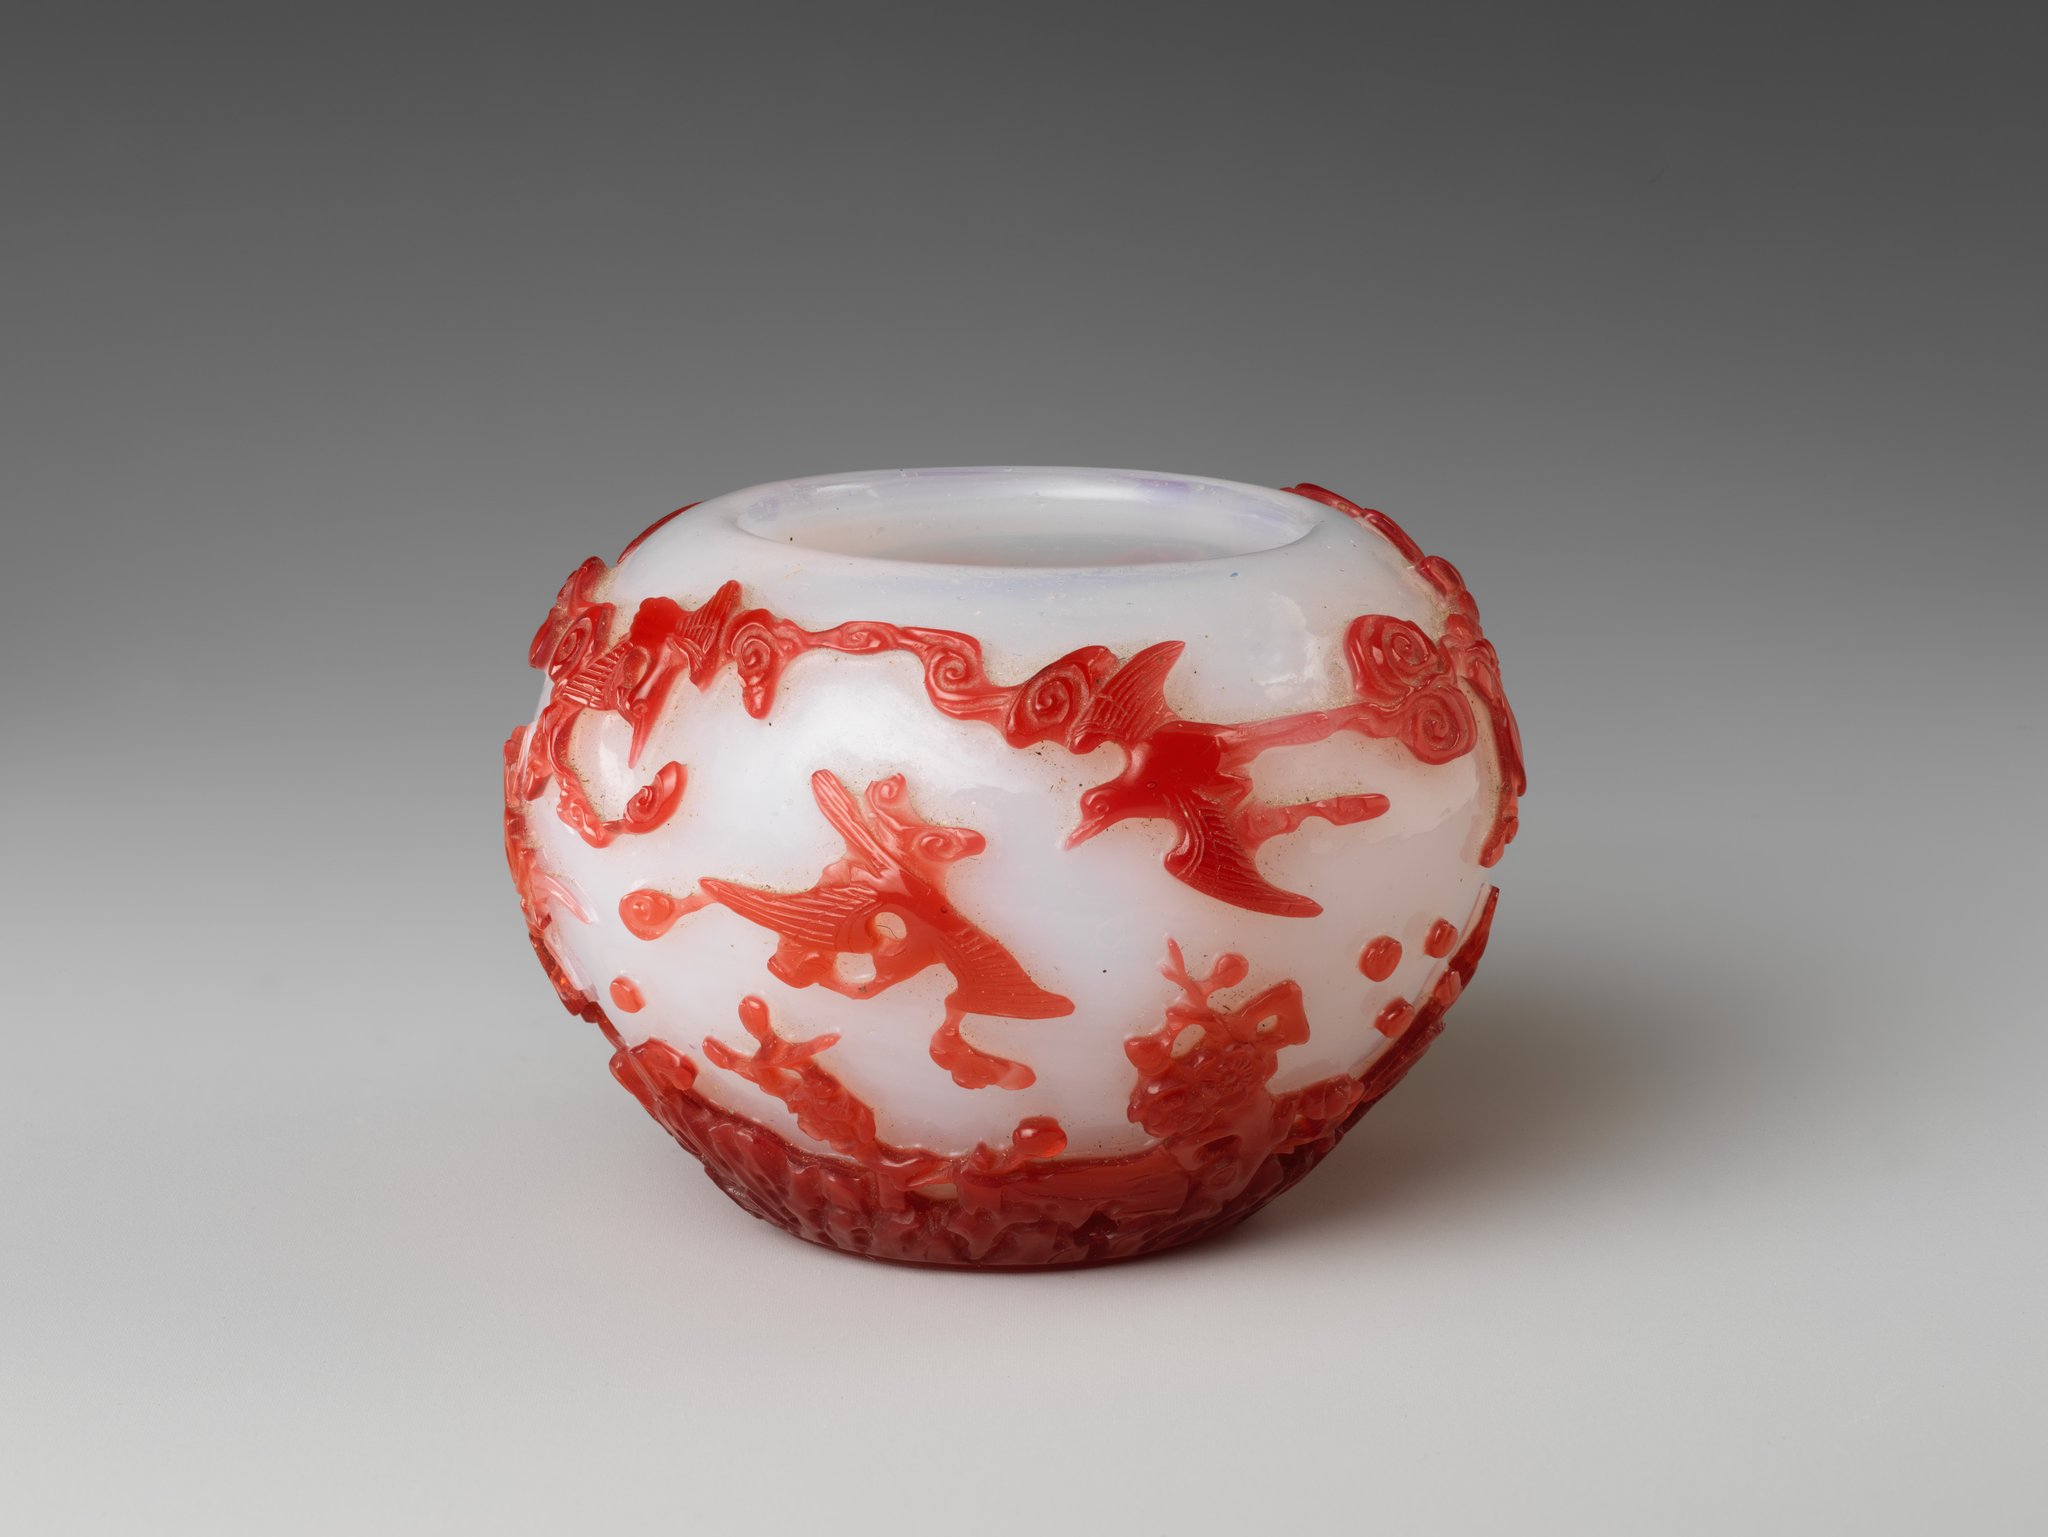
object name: bowl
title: Small bowl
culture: chinese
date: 1701-1800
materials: glass